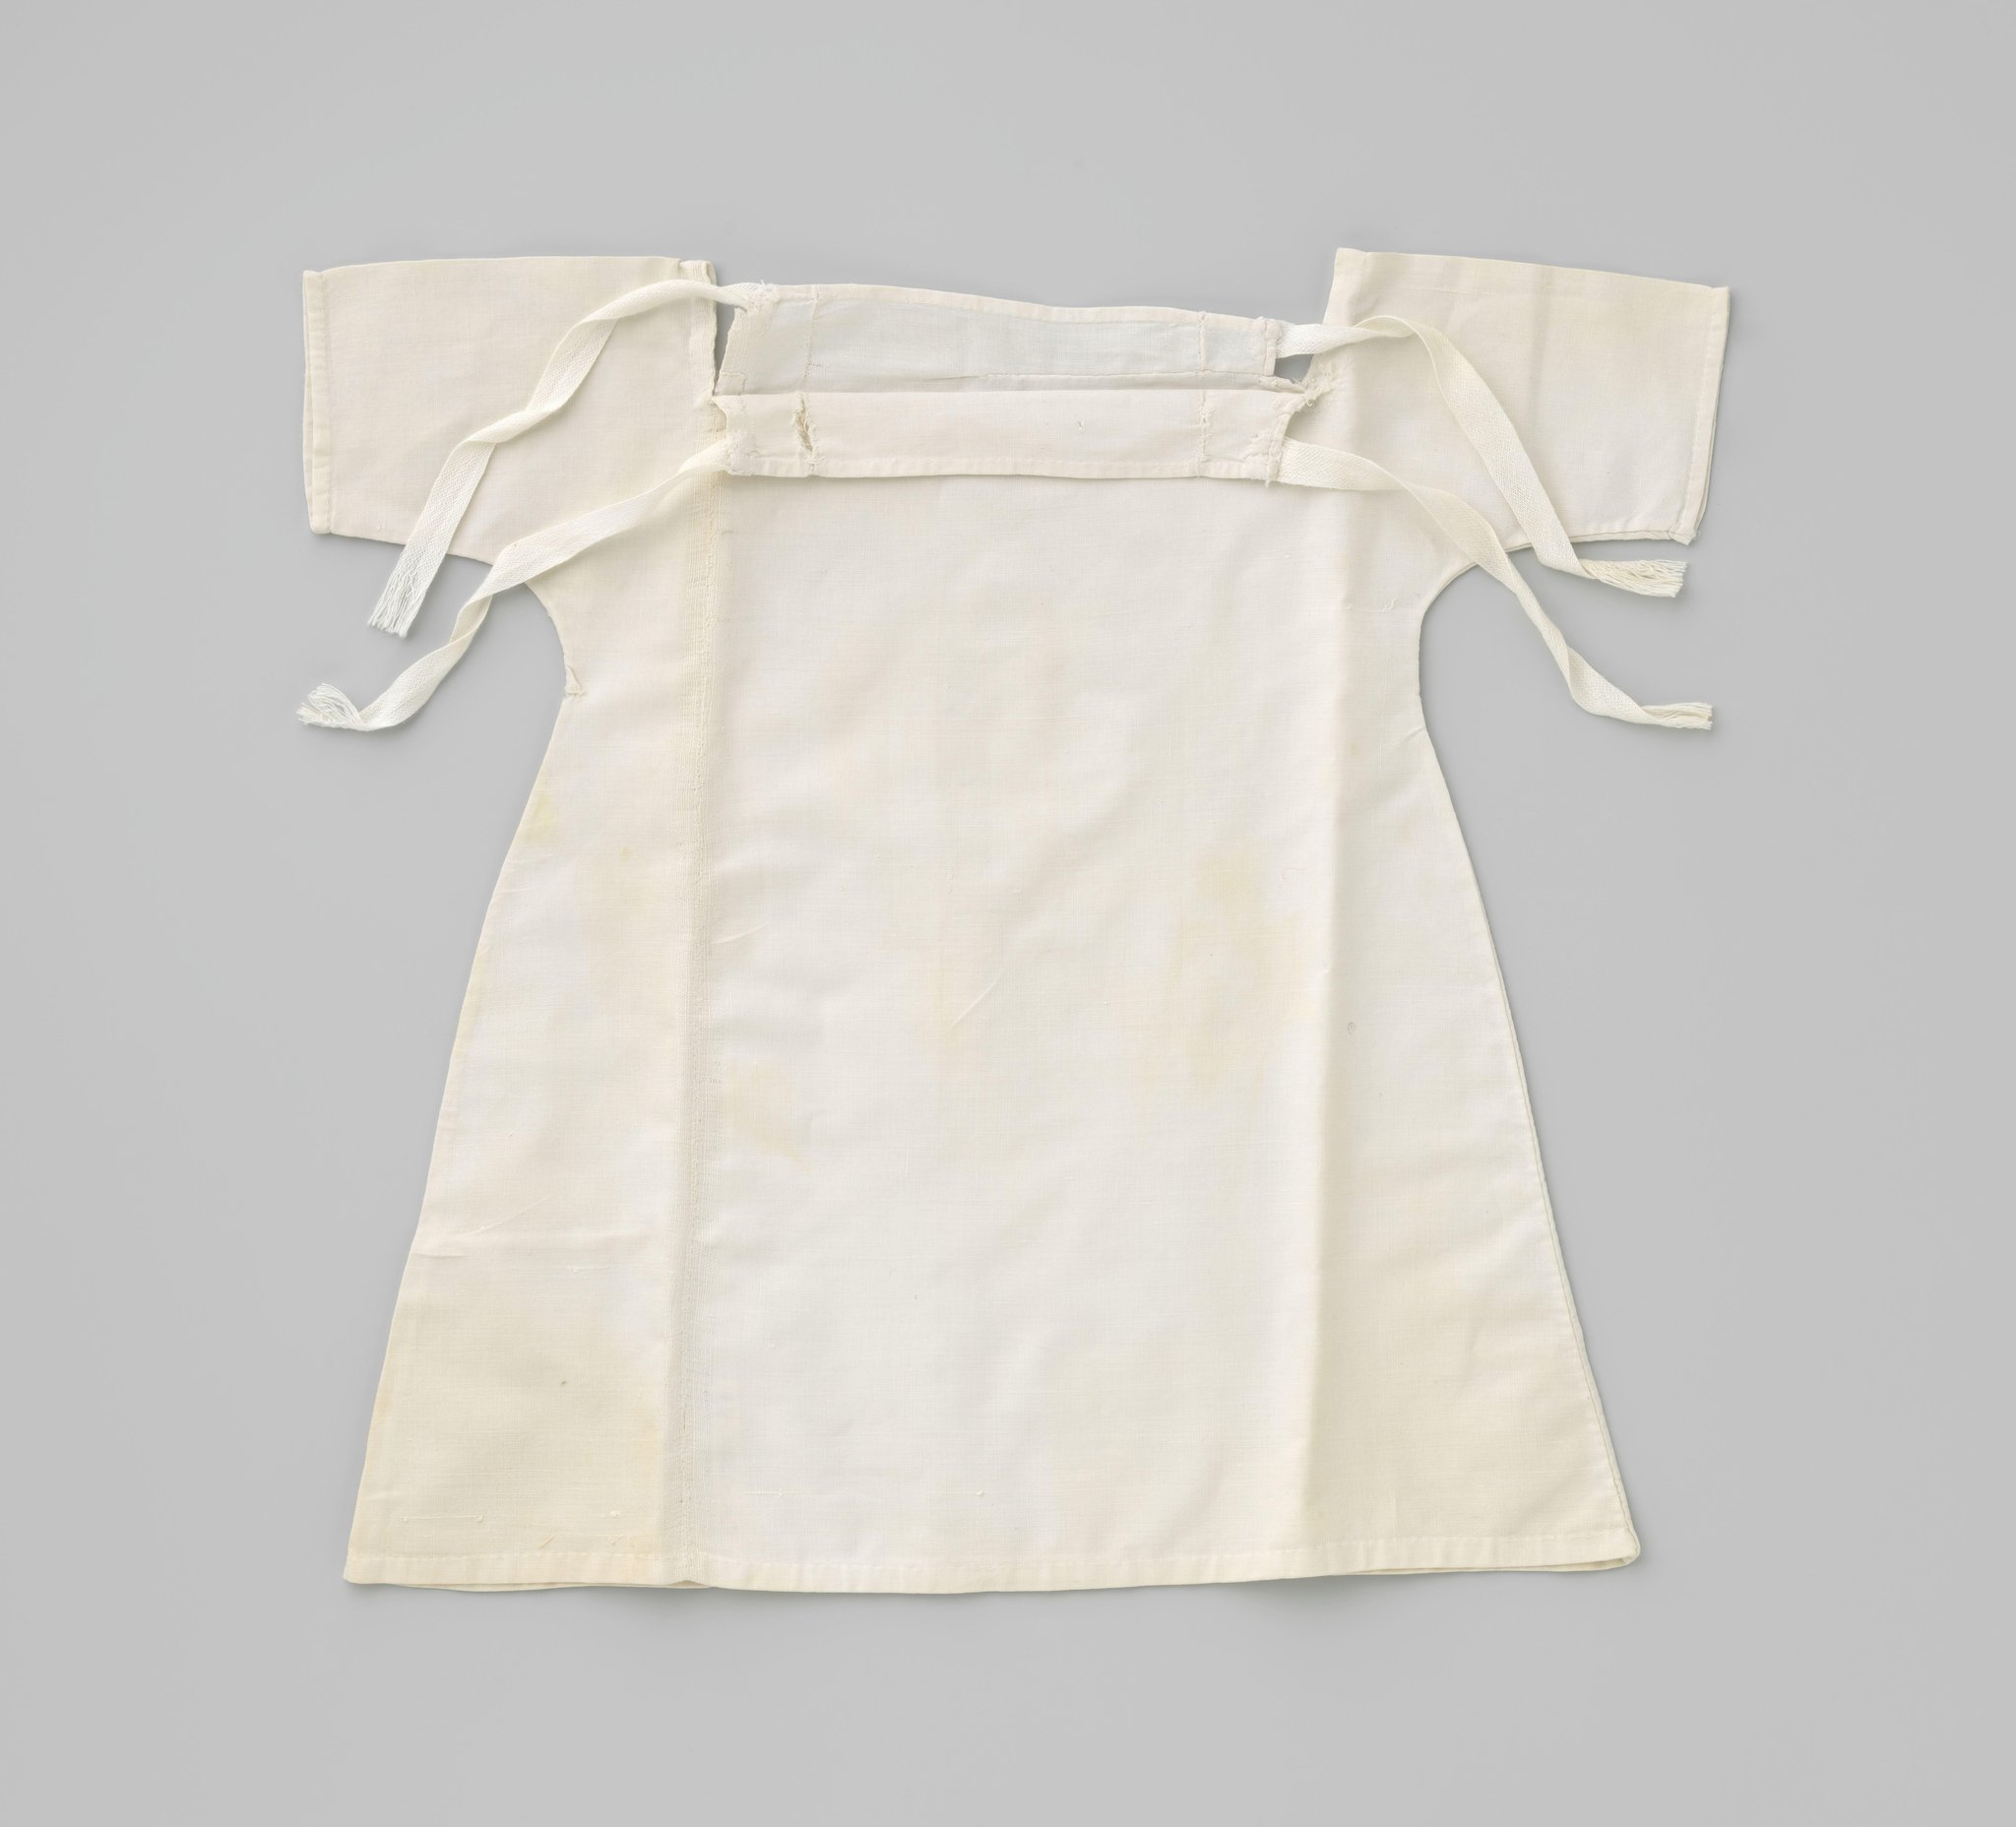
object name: chemise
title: Effen wit hemd met korte mouwen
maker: Anonymous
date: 1800-1920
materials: textile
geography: europe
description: Effen wit hemd met korte mouwen en linten aan de schouders.